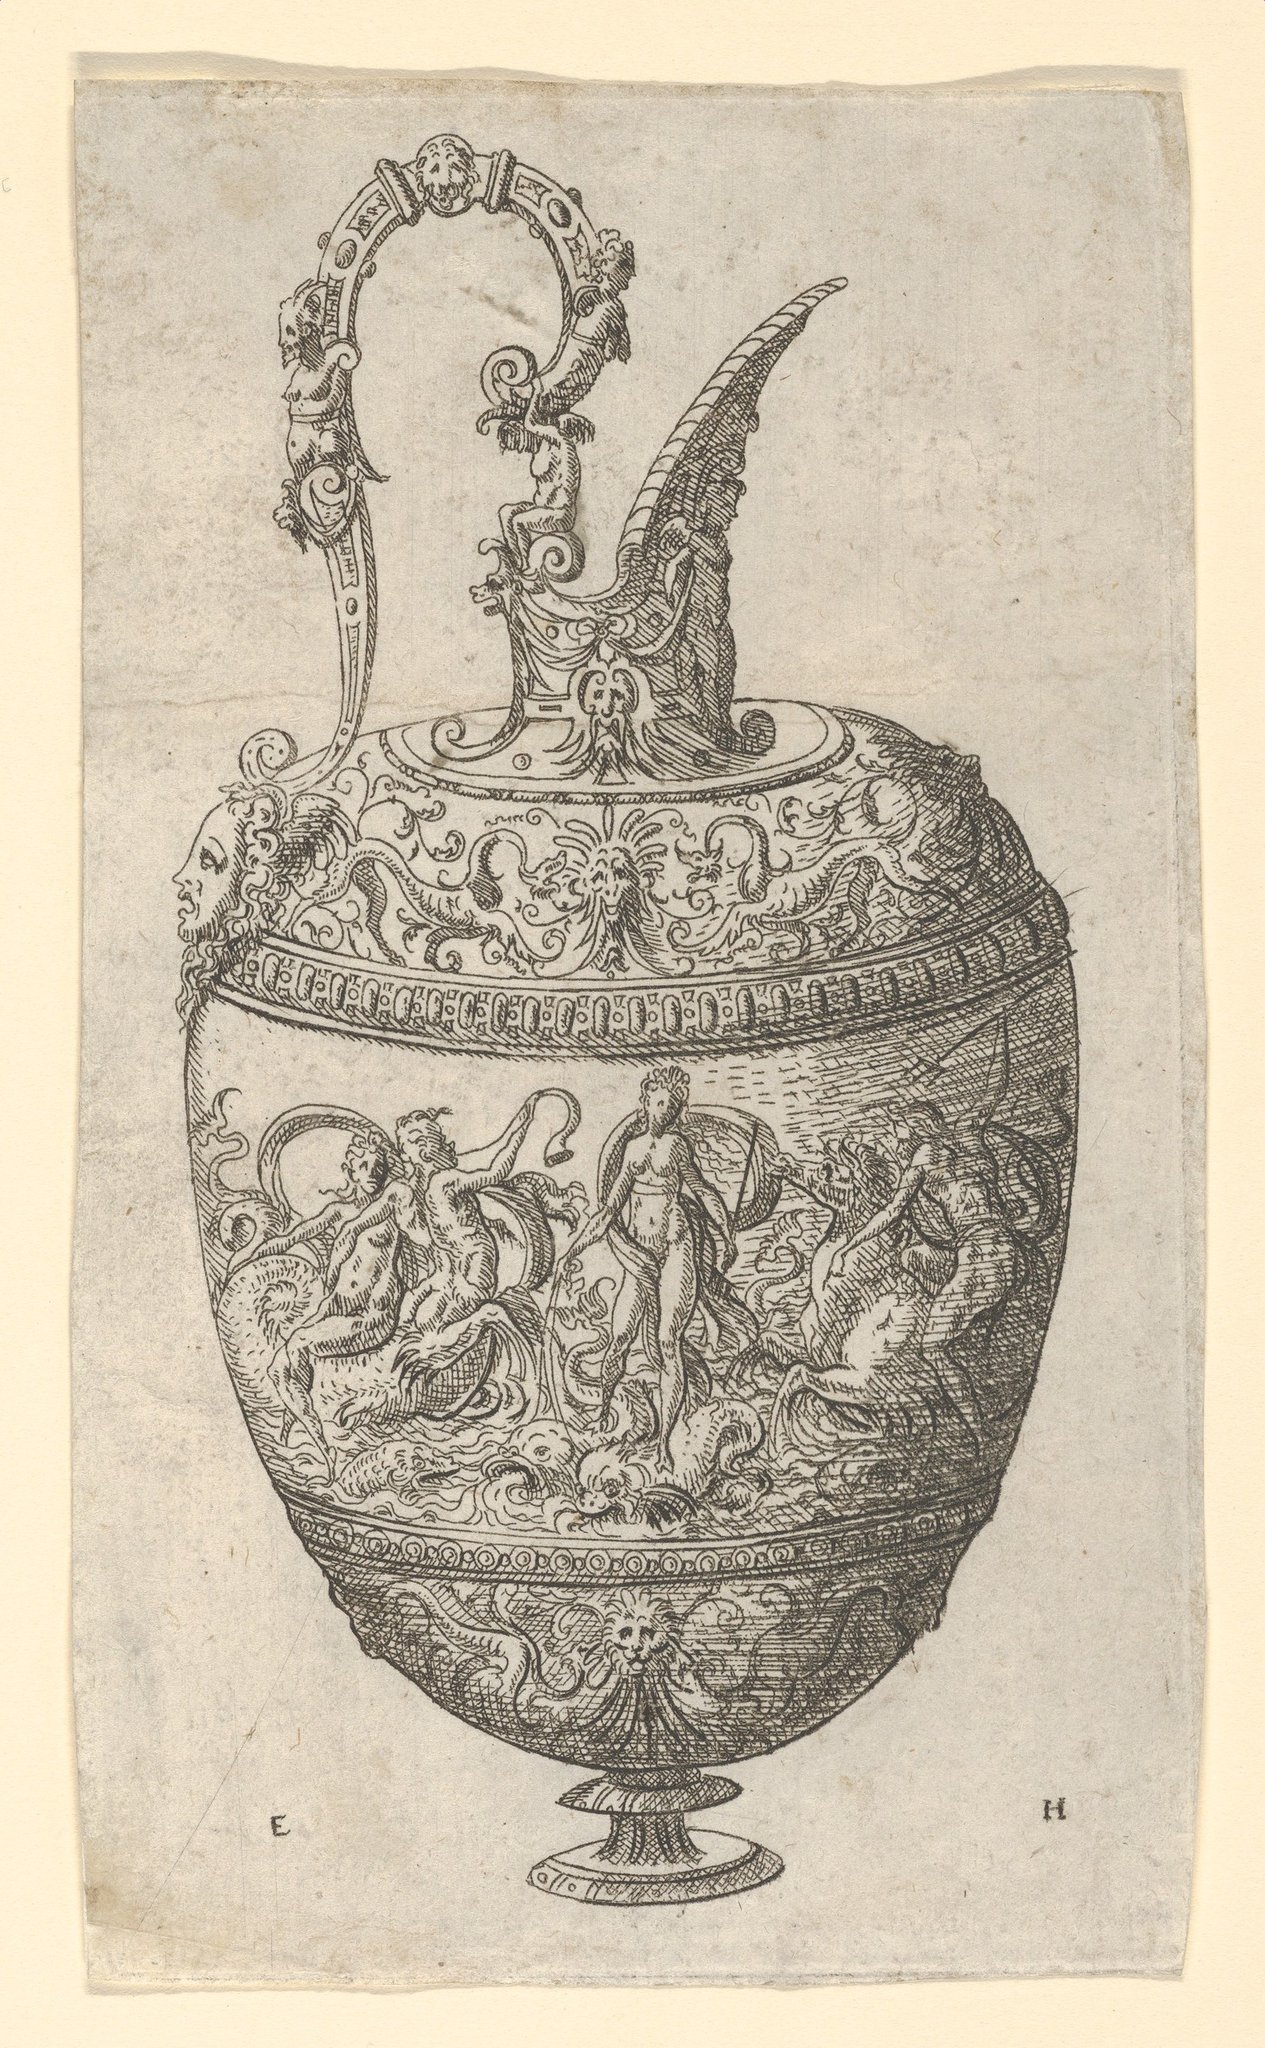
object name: print ornament architecture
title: Design for a Ewer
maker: erasmus hornick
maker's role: artist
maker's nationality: netherlandish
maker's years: 1501-1583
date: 1565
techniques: etching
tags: venus,ewers